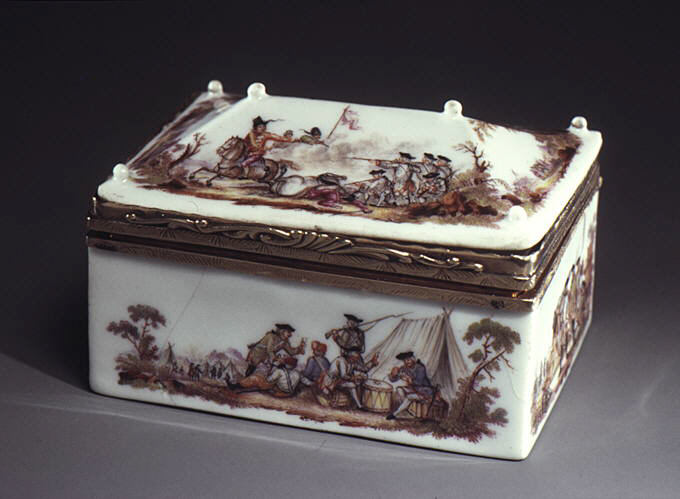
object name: snuffbox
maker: meissen manufactory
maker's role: manufactory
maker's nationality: german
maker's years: 1710-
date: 1750-1760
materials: gold, hard paste porcelain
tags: tents,firearms,men,horses